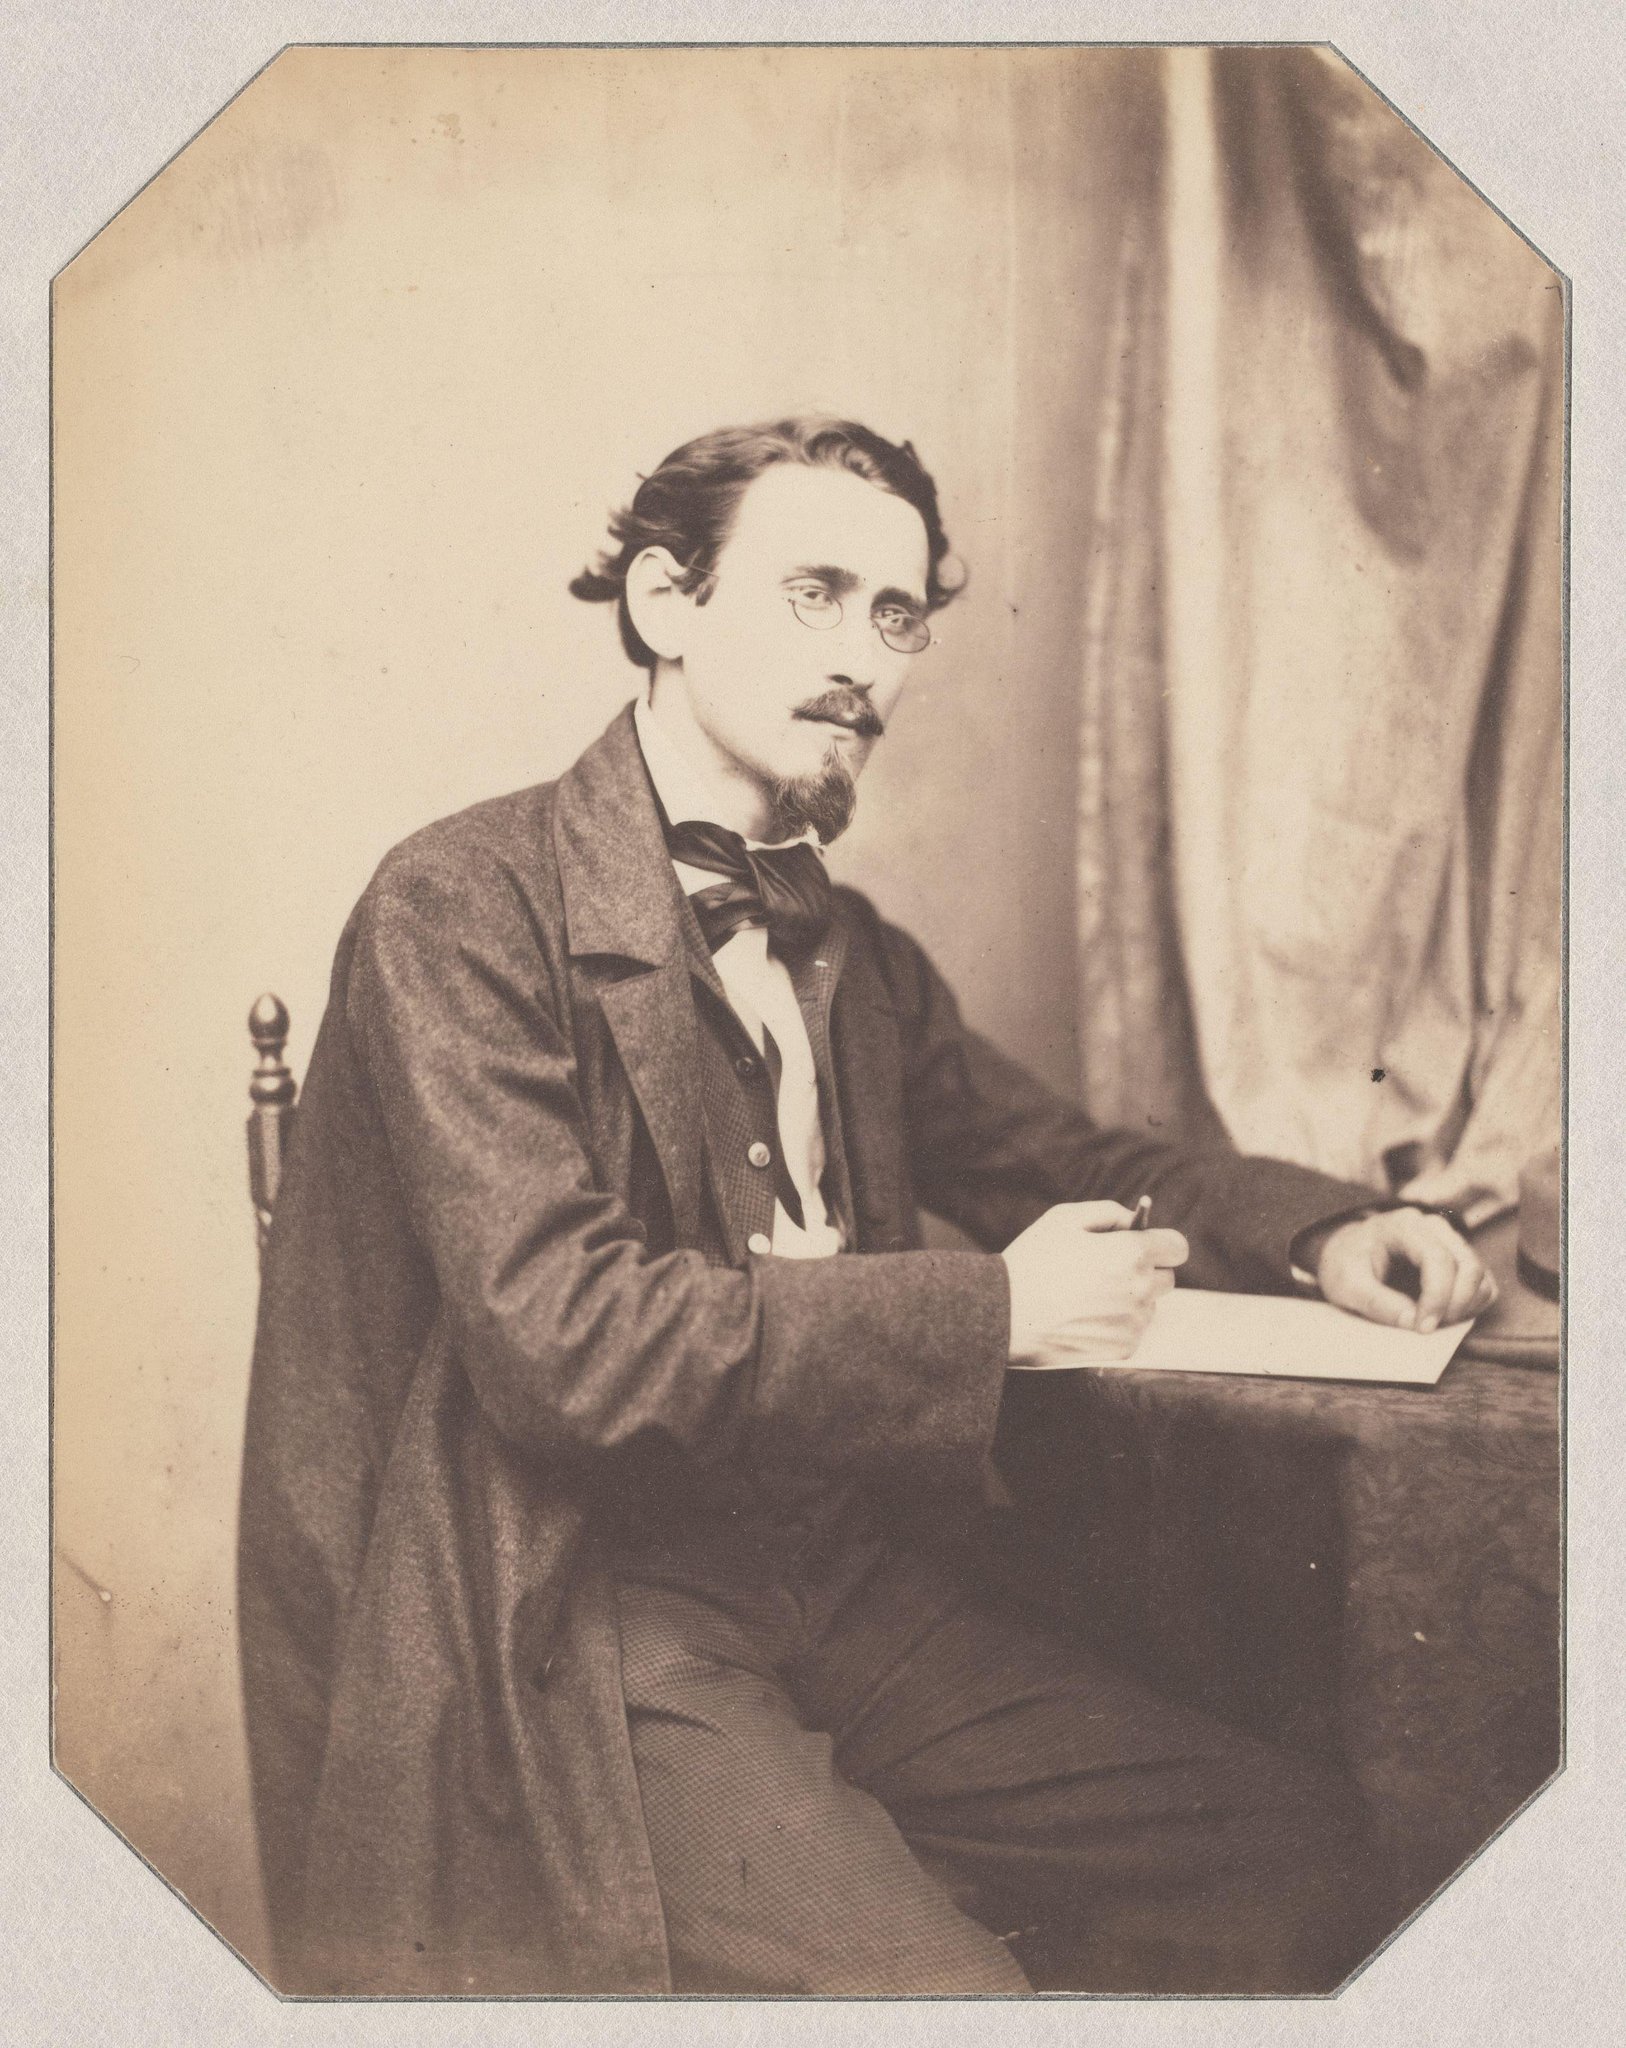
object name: photograph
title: Portret van mogelijk een architect, tekenend met potlood in zijn hand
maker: franz seraph hanfstaengl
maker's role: painter, print maker, printer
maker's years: 1804-1877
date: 1855-1860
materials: cardboard, paper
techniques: salted paper print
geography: germany